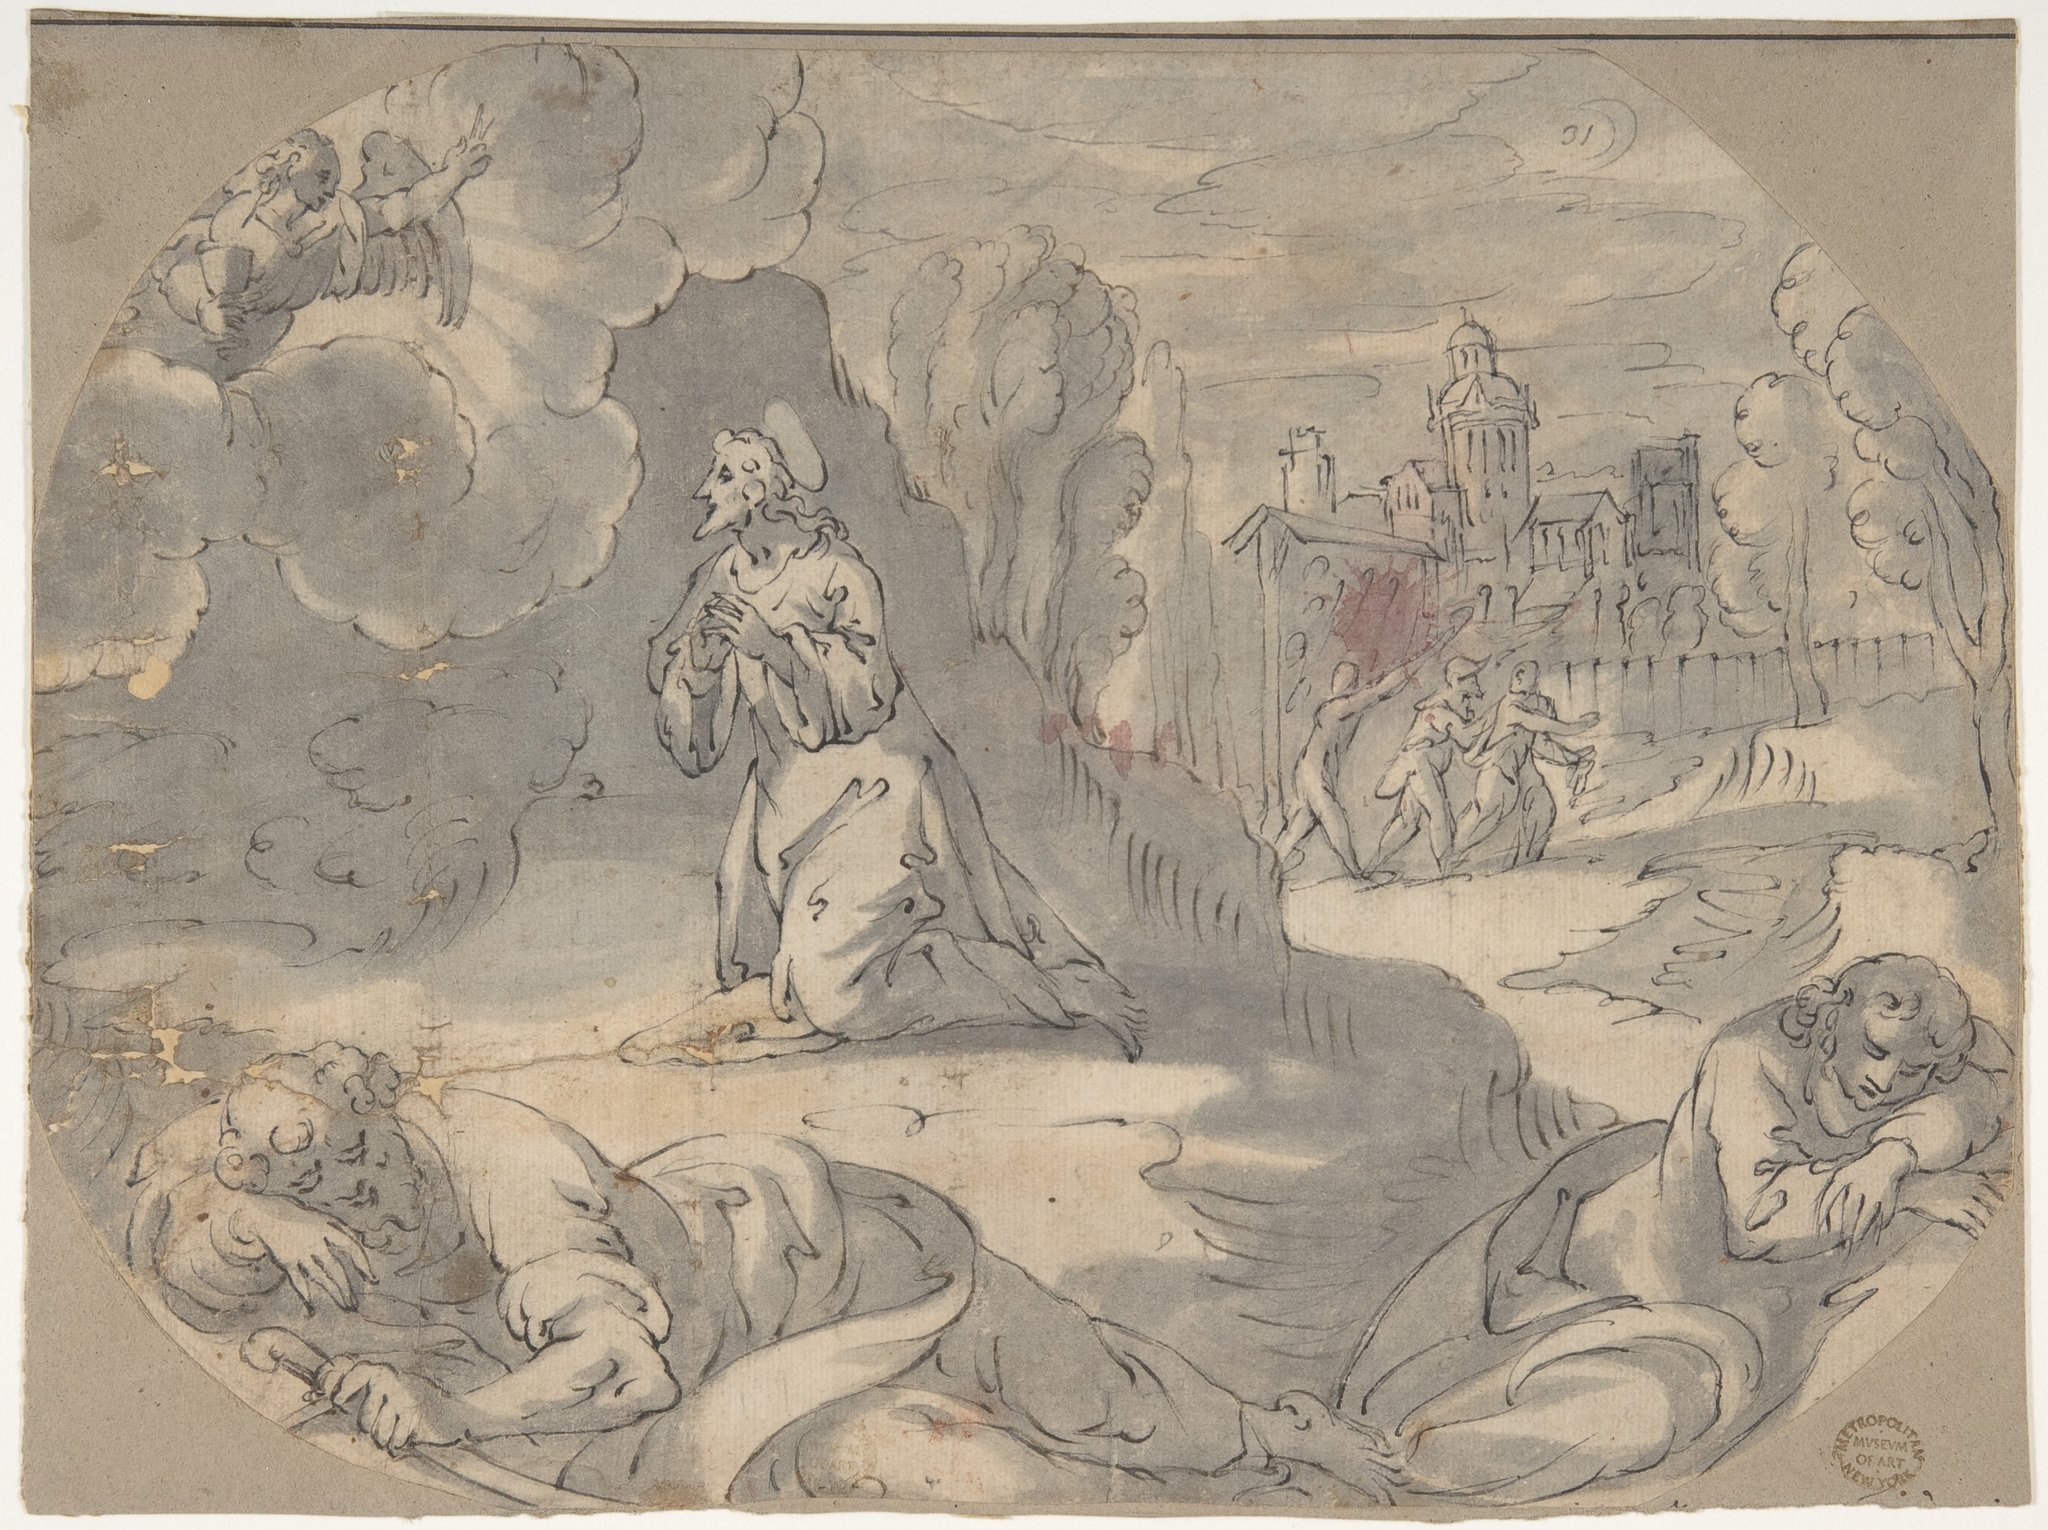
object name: drawing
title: Christ in the Garden of Gethsemane (Matthew 26:36-46)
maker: anonymous, german, 16th century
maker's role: artist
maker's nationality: german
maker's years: 1500-1600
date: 1600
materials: ink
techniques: brush, pen, drawing, wash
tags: gardens,men,christ